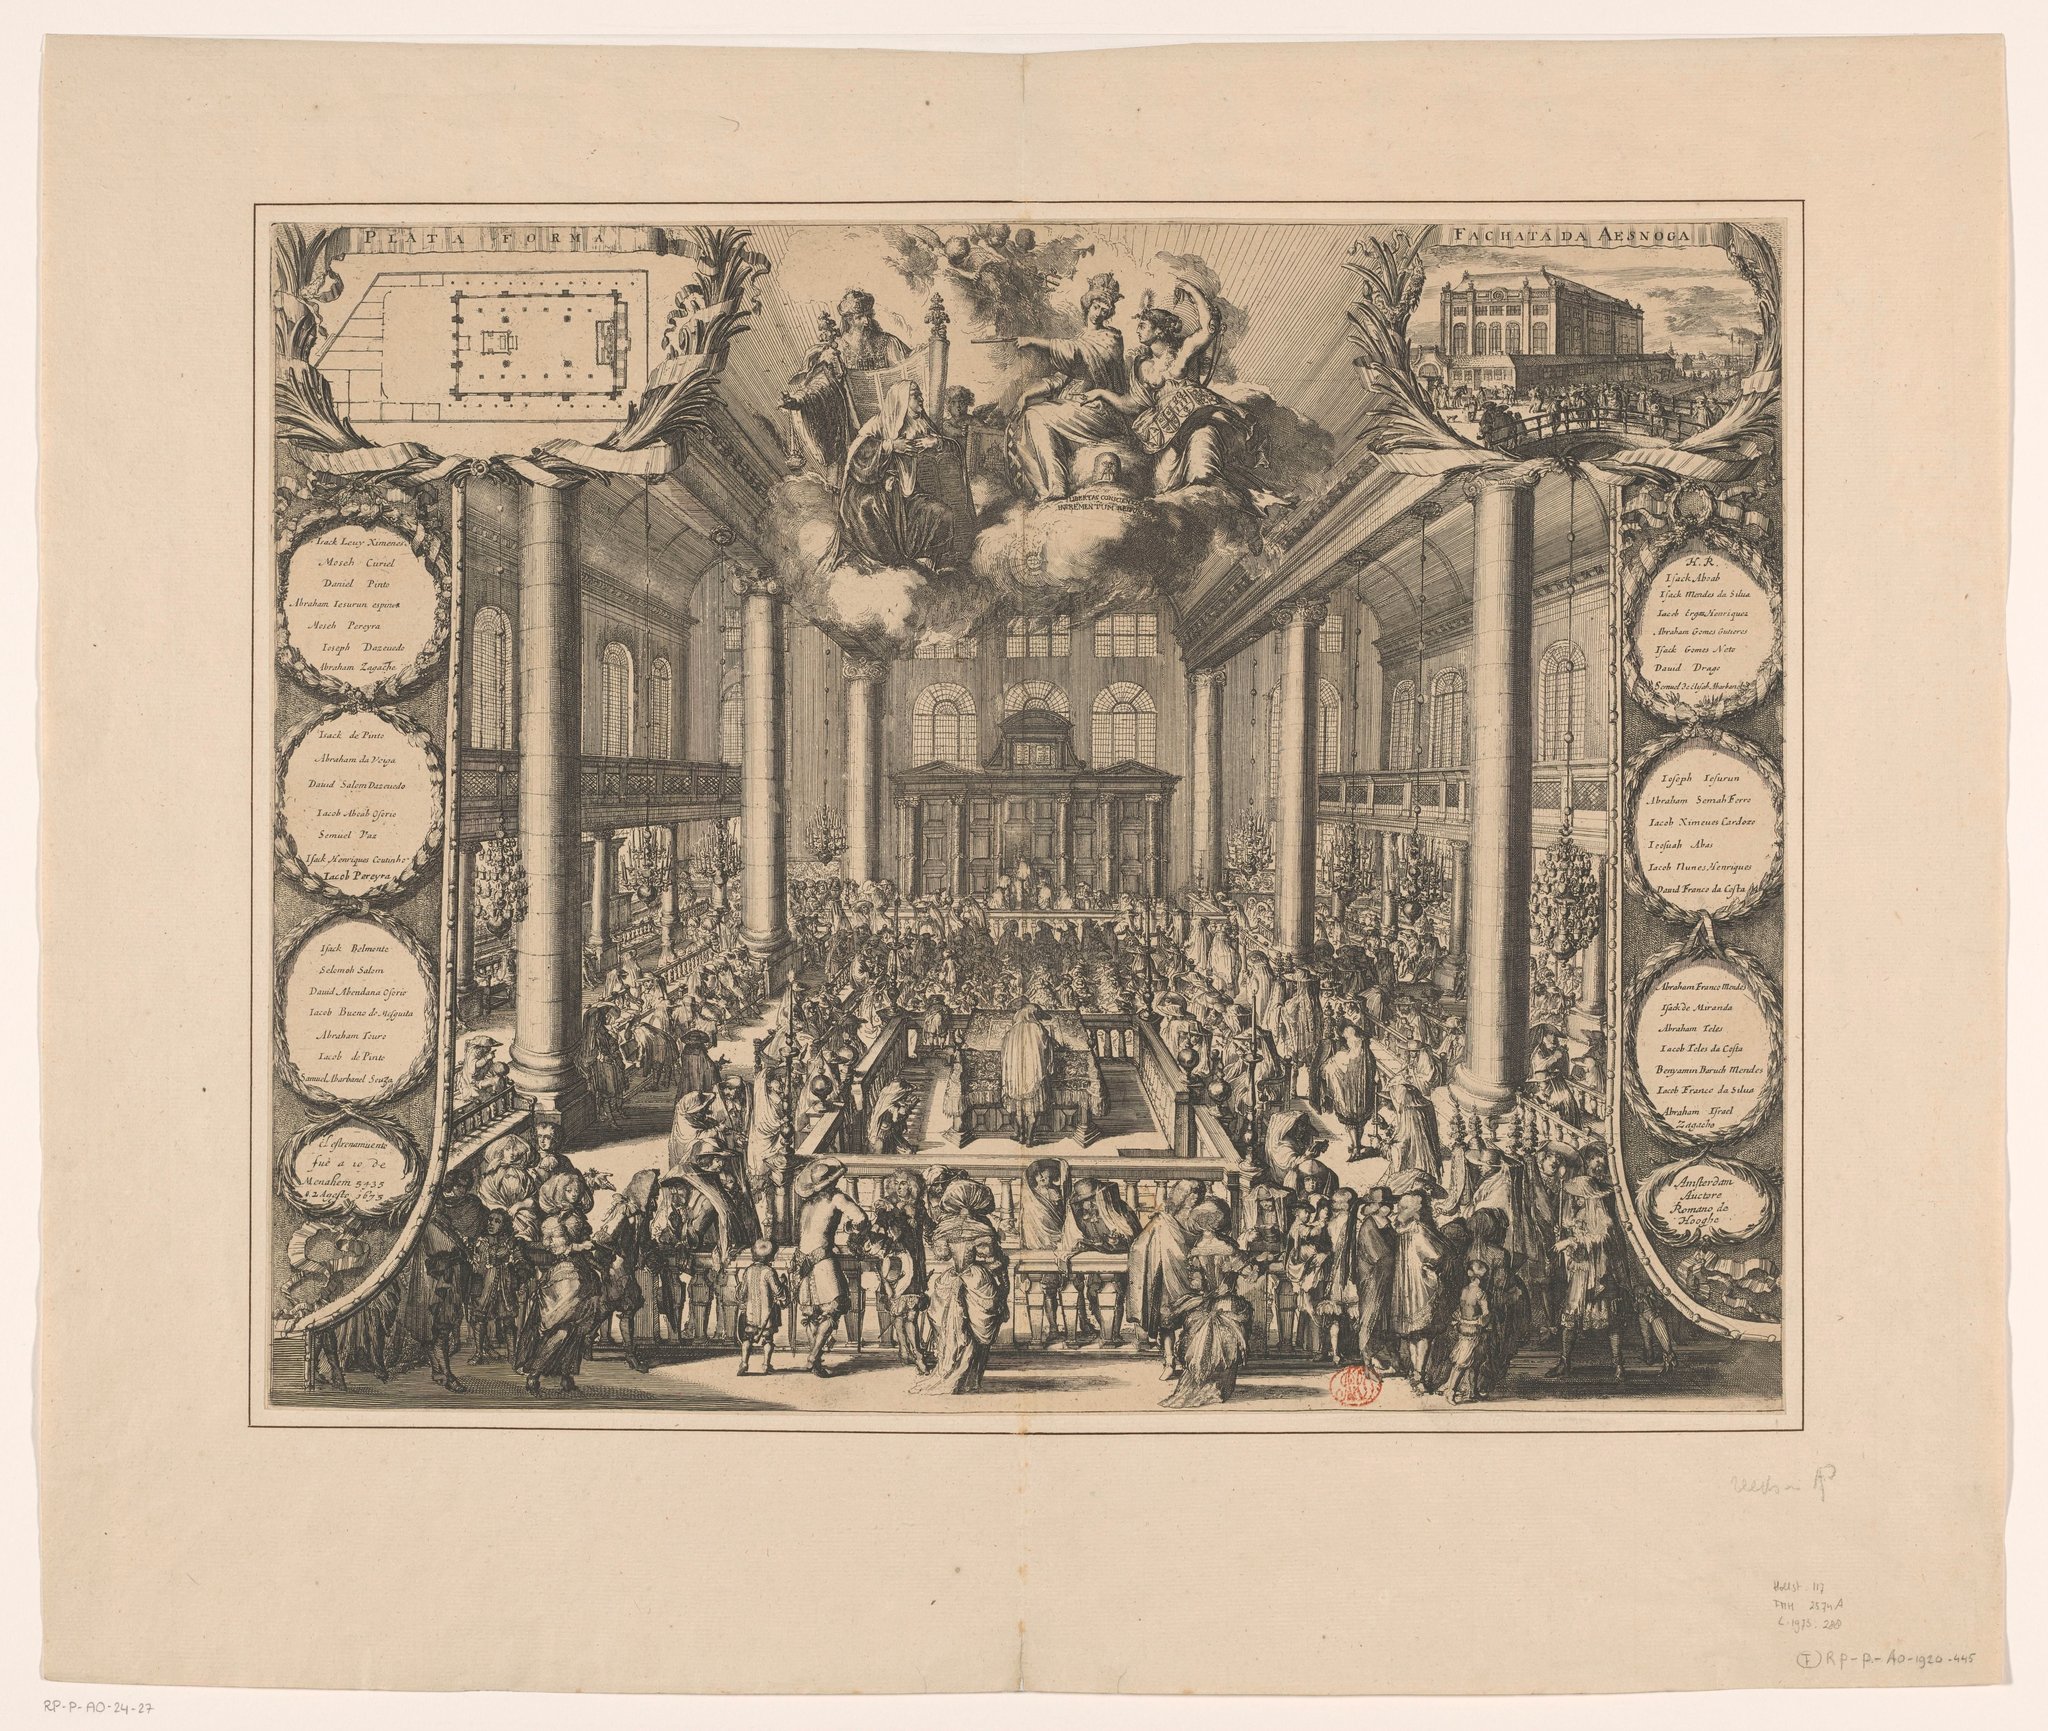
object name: print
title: Interieur van de Portugese Synagoge te Amsterdam tijdens de inwijding, 1675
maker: romeyn de hooghe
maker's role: draughtsman, goldsmith, painter, print maker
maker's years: 1645-1708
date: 1675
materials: paper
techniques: engraving, etching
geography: amsterdam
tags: 'sephardim' ~ jewish communities, the synagogue (as building and place of worship ~ jewish religion)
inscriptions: collector's mark: Lugt 2233, collector's mark: Lugt 195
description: Gezicht op het interieur van de Portugese Synagoge te Amsterdam tijdens de inwijding op 2 augustus 1675. In het midden, op de naar het oosten gerichte teba, de chazan. Rechts worden de torarollen, gedragen door mannen en afgewisseld door mannen met een fakkel of een kaars, in een stoet naar de heilige ark (aron hakodesj of hechal) gedragen. Boven in het midden geven de Amsterdamse Stedenmaagd en de personificatie van Vrijheid van Geweten een Joodse priester met gebedsrol en een knielende vrouw met wetstafelen de vrijheid om hun godsdienst uit te oefenen. Links hiervan een plattegrond van de tempel, rechts een gezicht op de buitenkant. Aan weerszijden medaillons met de namen van regenten van de synagoge, leden van de bouwcommissie en personen die tijdens de inwijding ceremonies uitvoerden.